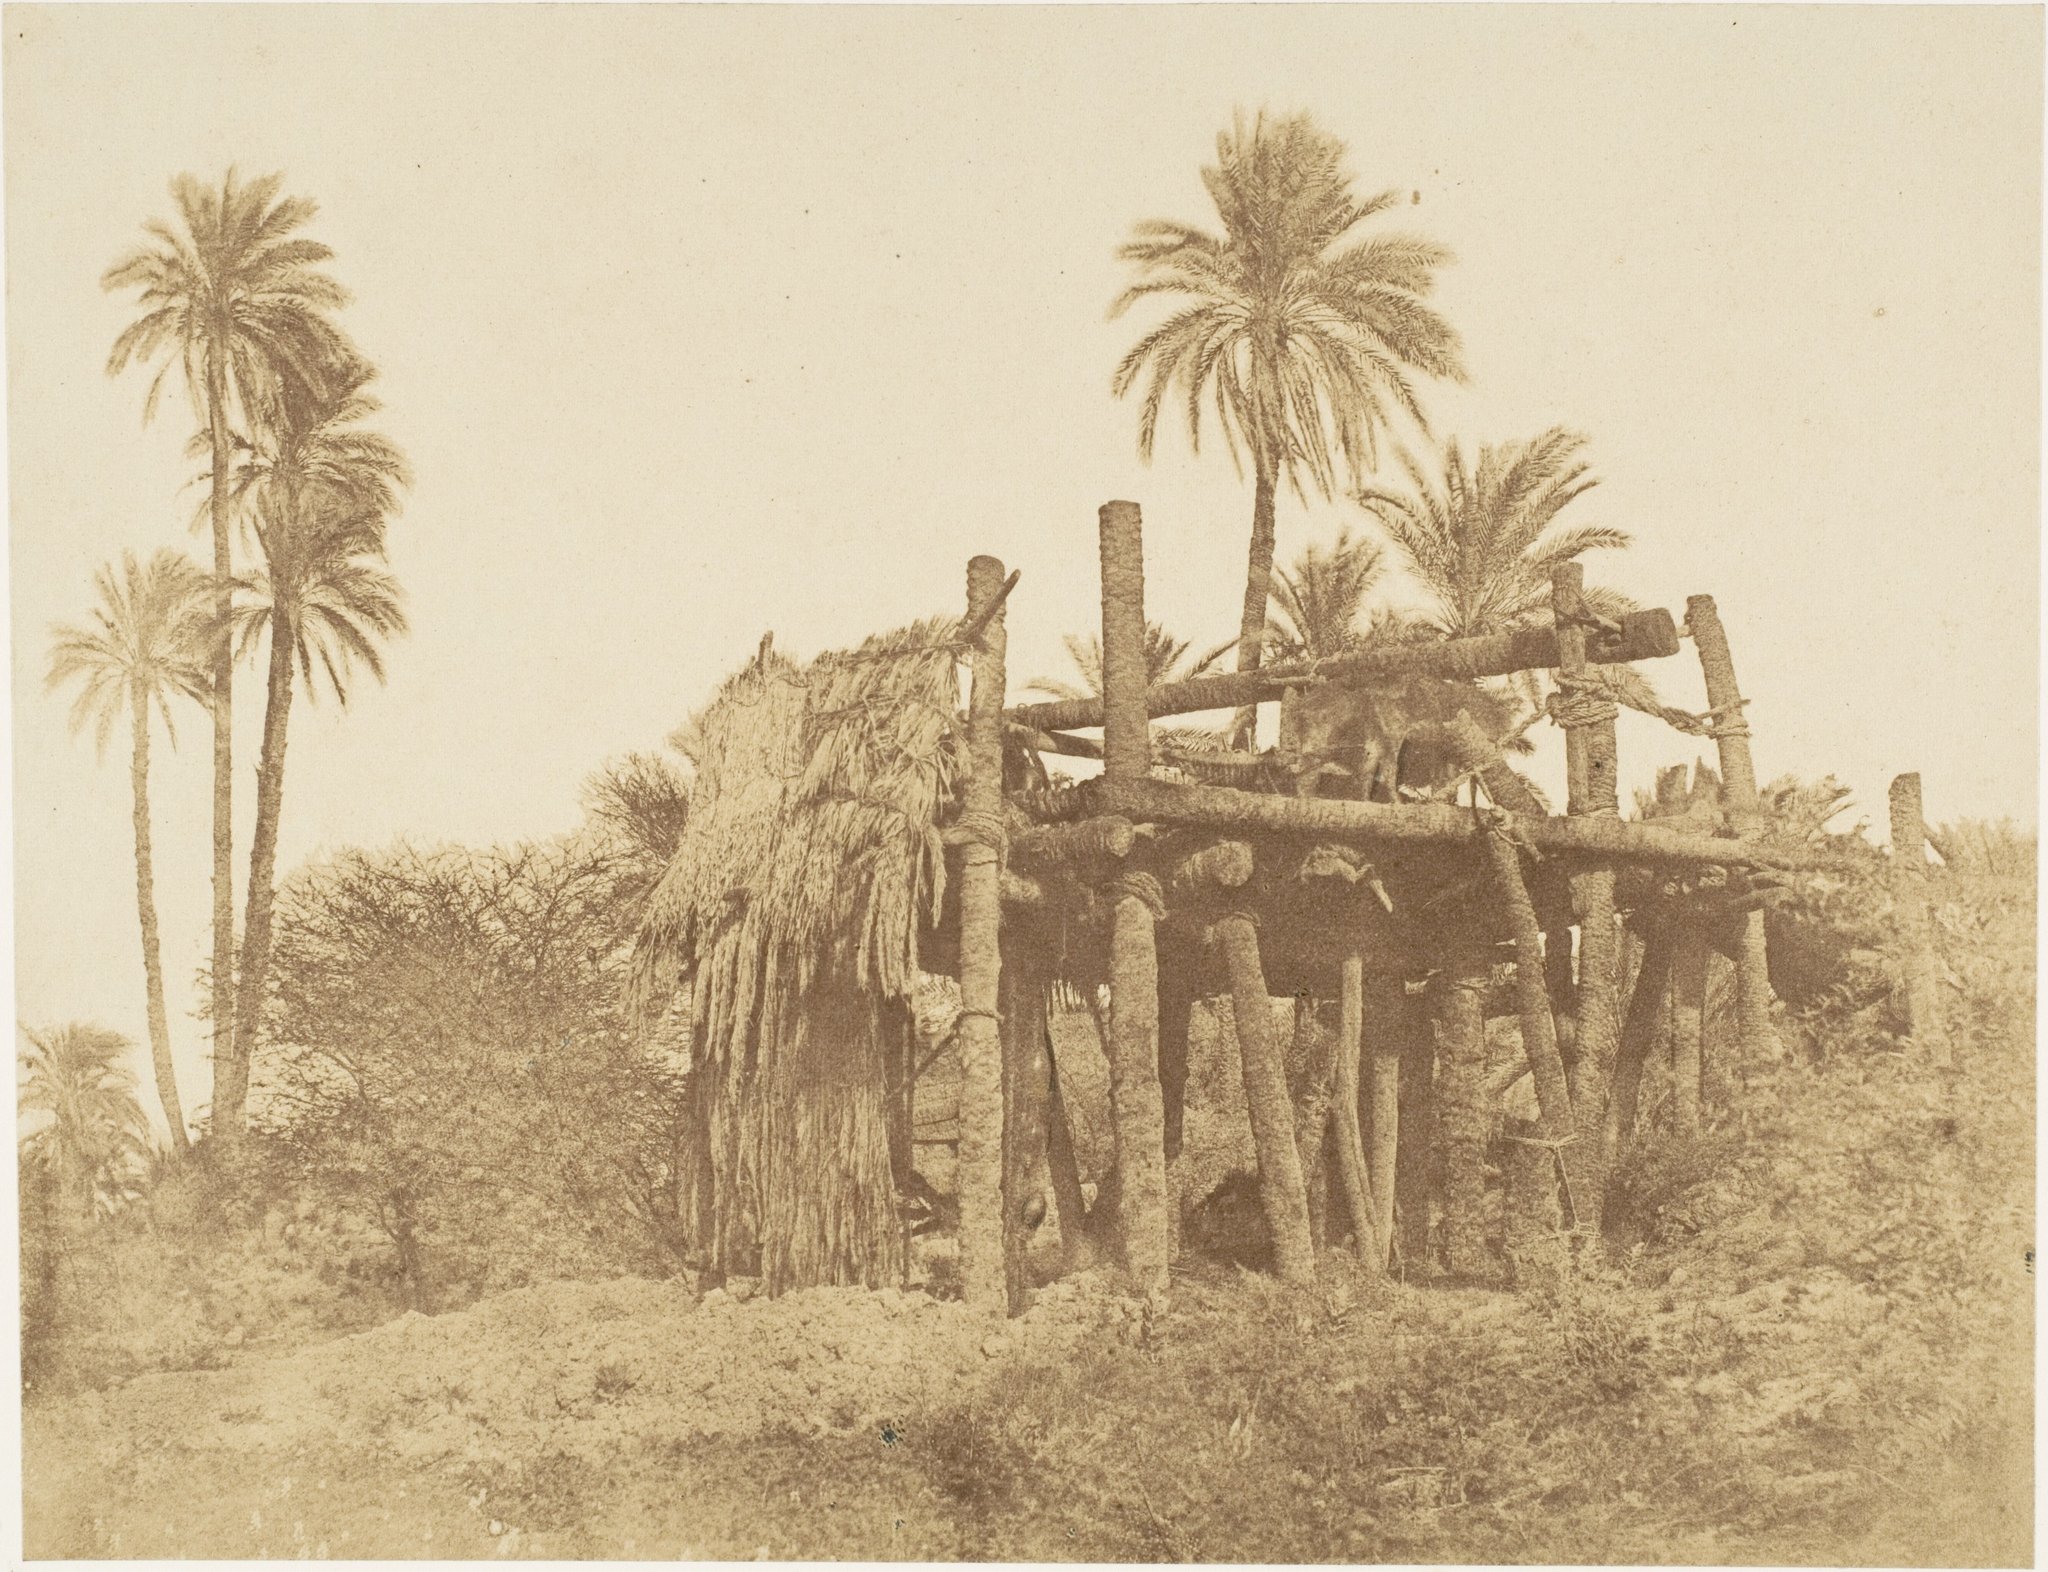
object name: photograph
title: Nubian Sakkieh, or Water Wheel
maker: robert murray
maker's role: artist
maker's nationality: british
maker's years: 1822-1893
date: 1856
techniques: albumen silver print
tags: landscapes